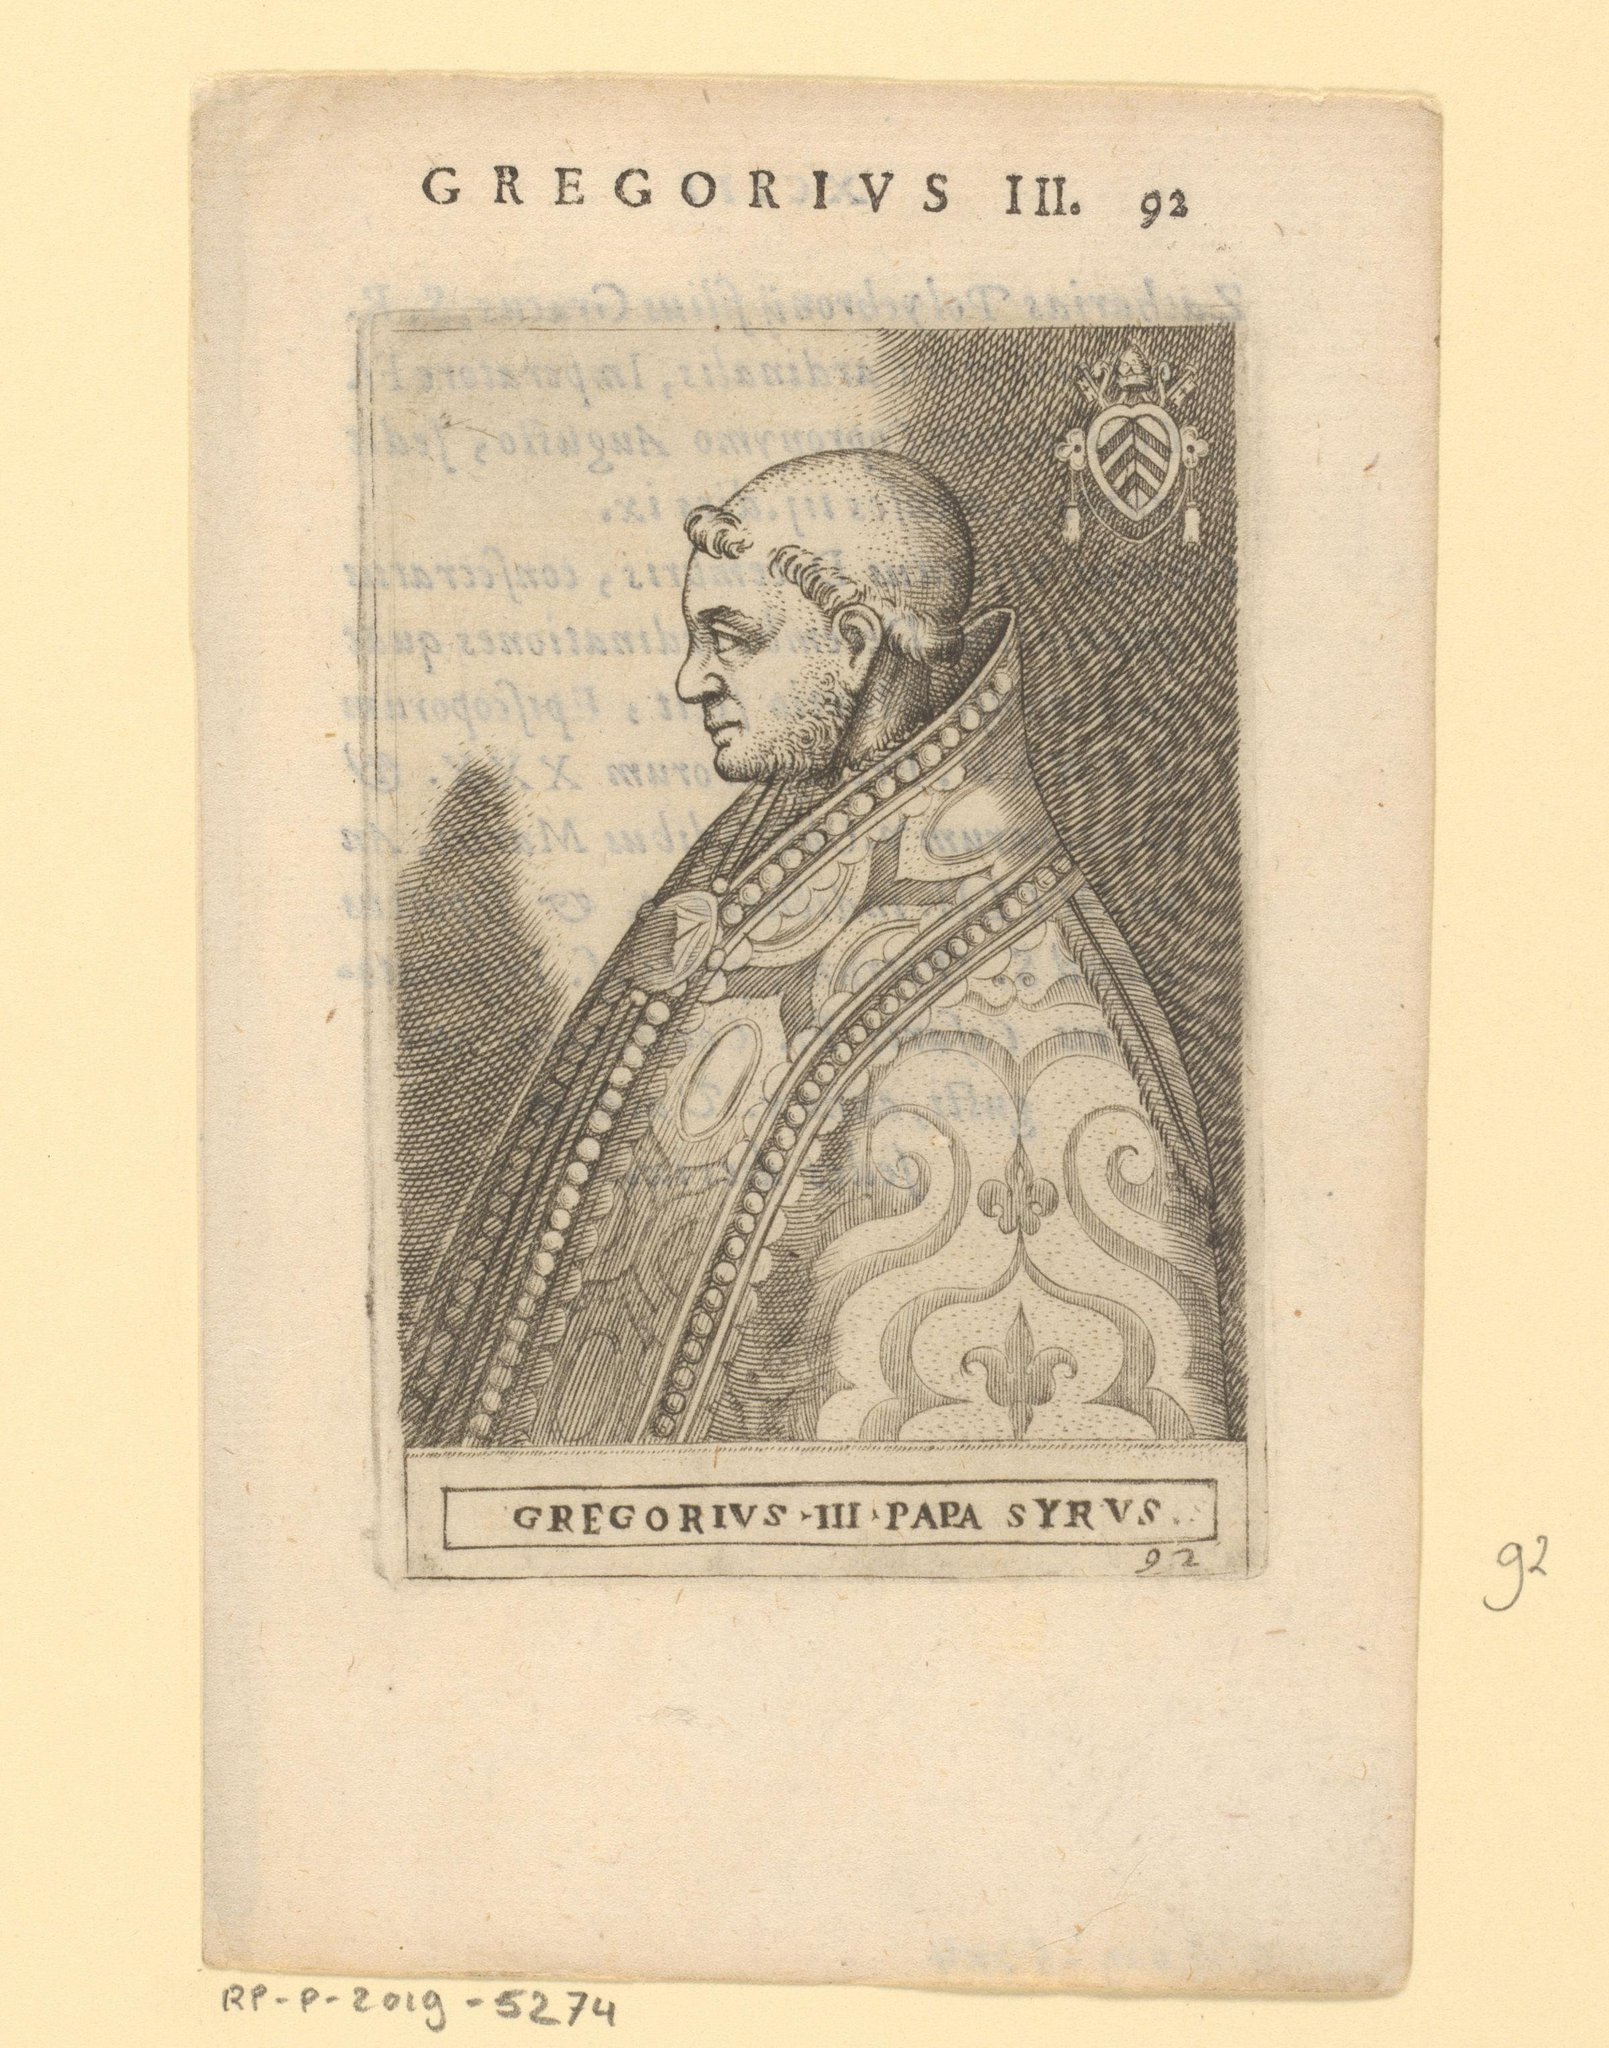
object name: book illustration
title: Portret van paus Gregorius III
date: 1595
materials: paper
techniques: engraving, letterpress printing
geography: rome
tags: historical persons, pope, armorial bearing, heraldry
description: Prent uit: Cavalieri, Giovanni Battista de'. Effigies pontificum romanorum cum eorum vitis (...). Rome: Bartolomeo Bonfadino, 1595. Prent voor het eerst verschenen in: Cavalieri, Giovanni Battista de'. Pontificum romanorum effigies (...). Rome: Domenico Basa en Francesco Zanetti, 1580. Prent ook gebruikt in latere publicaties.